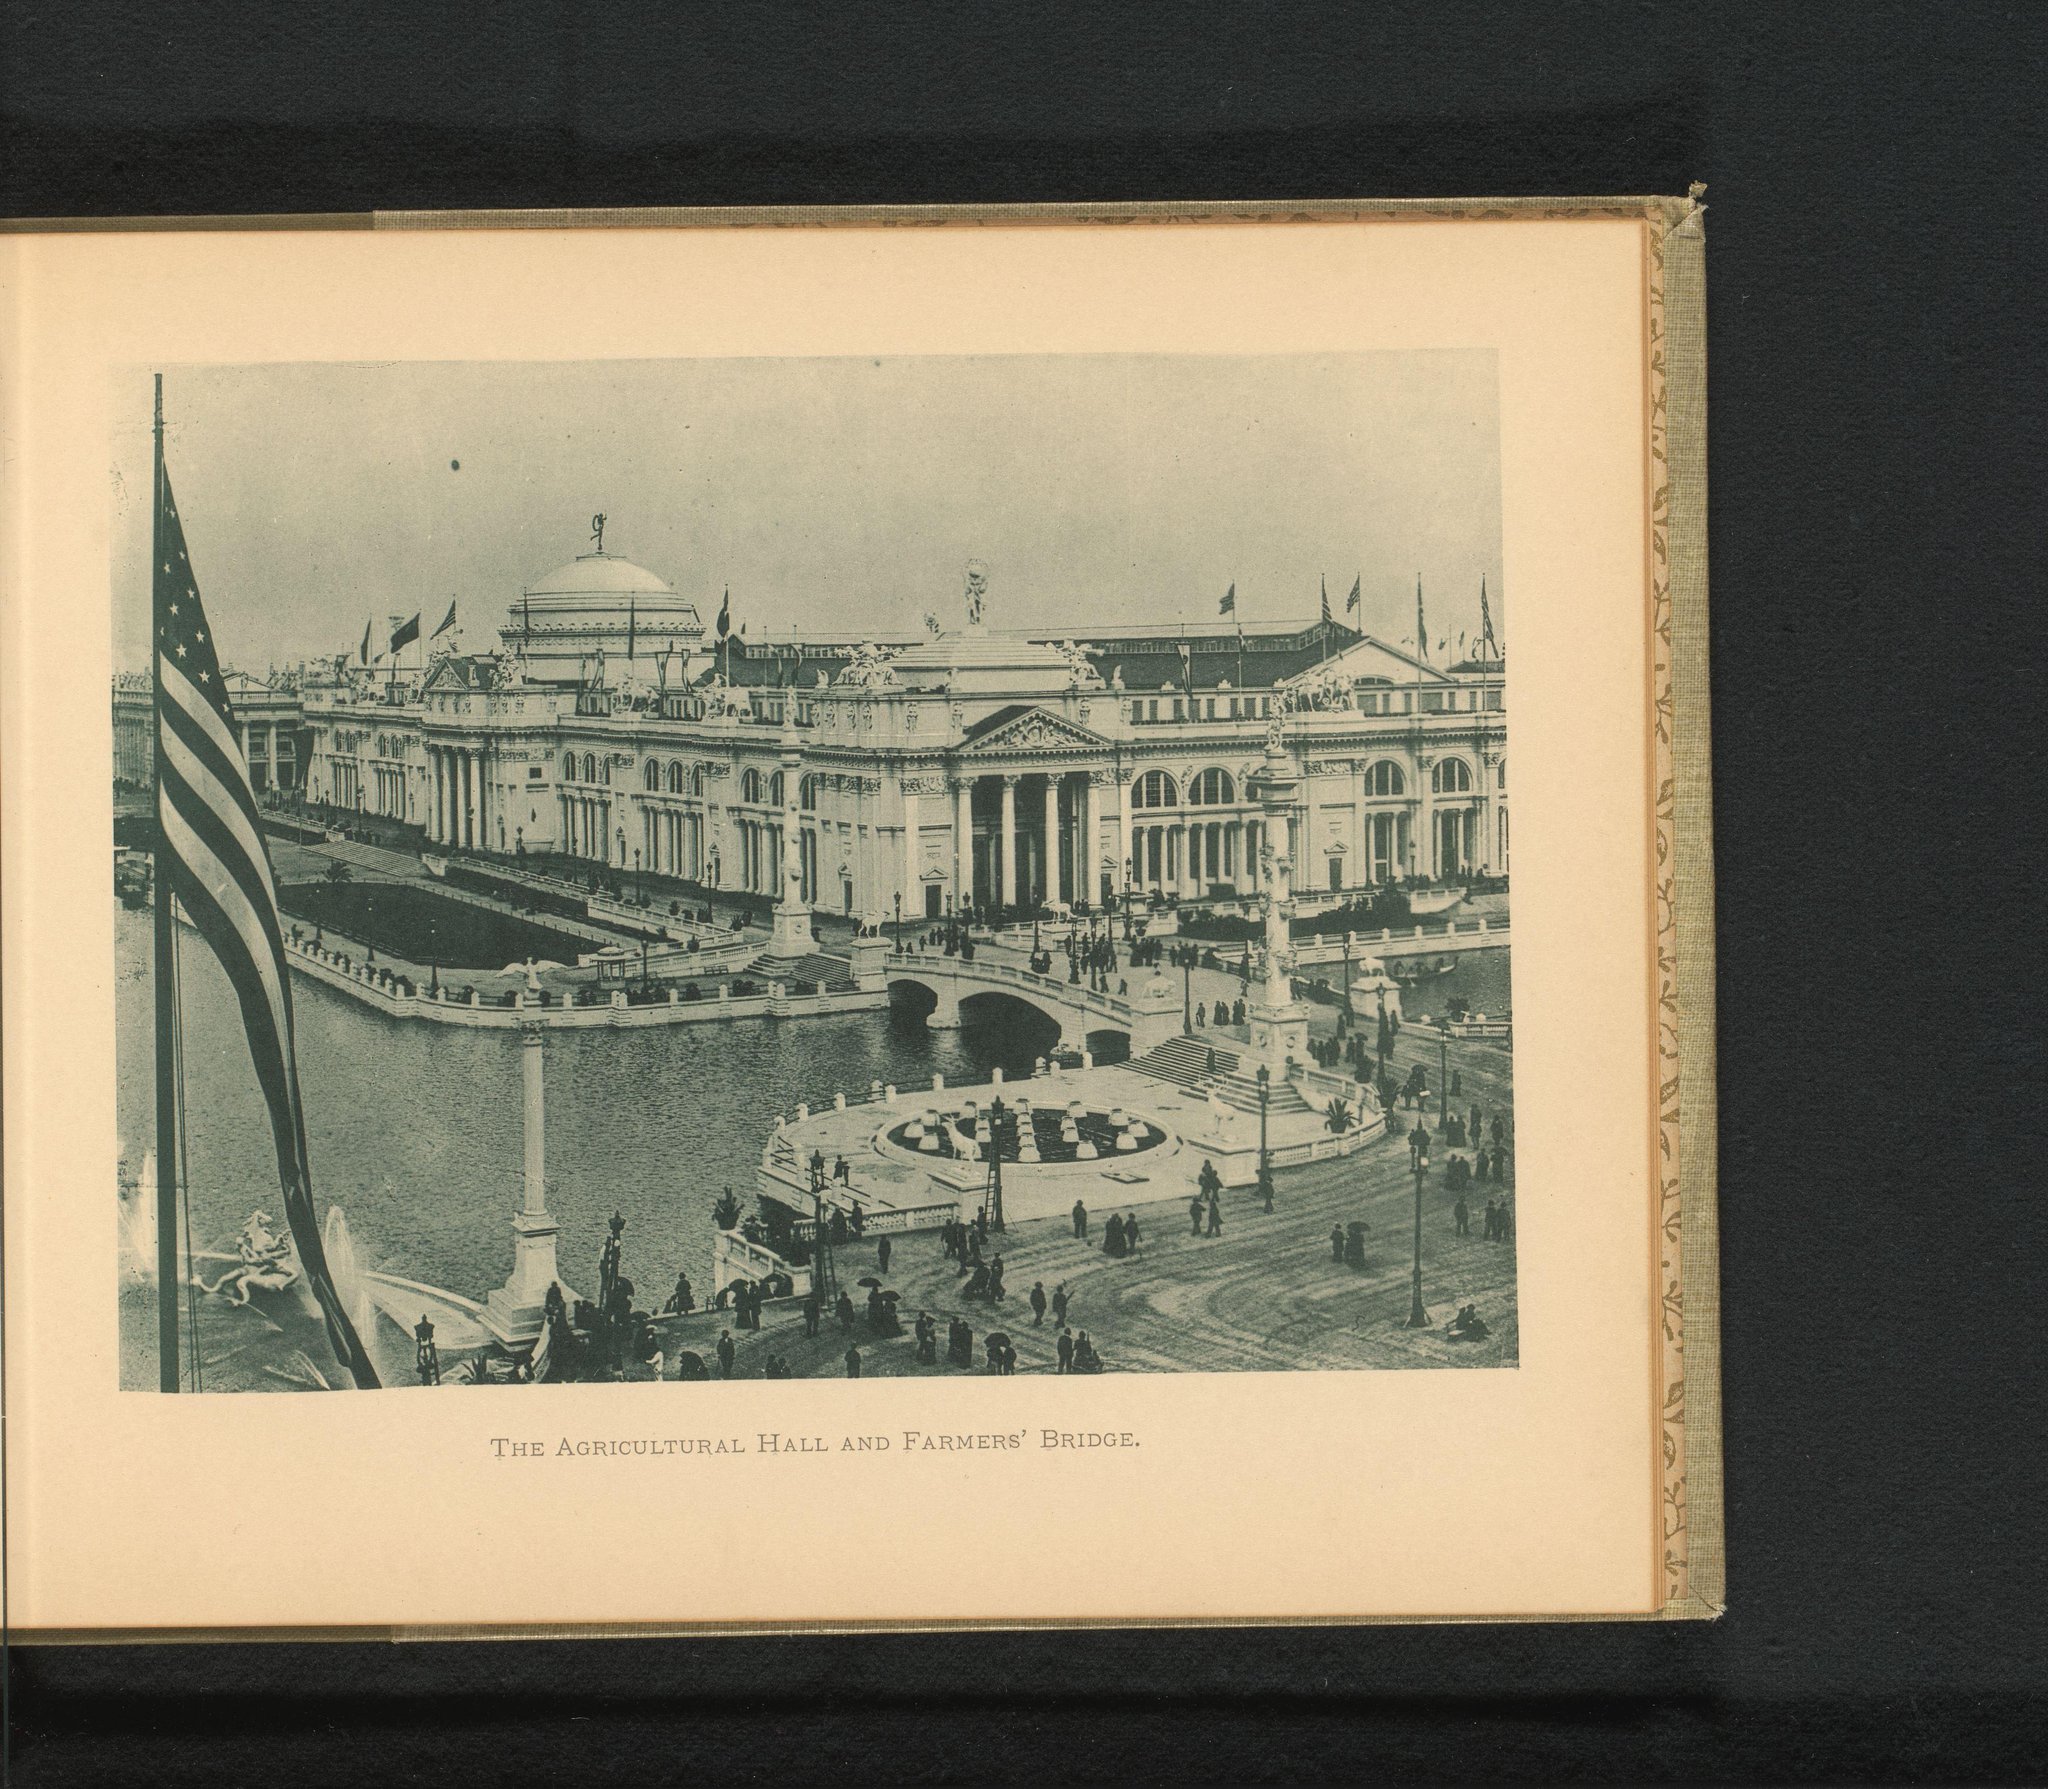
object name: page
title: Gezicht op het landbouwgebouw, ontworpen door Charles McKim op de World's Columbian Exposition in Chicago in 1893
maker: Anonymous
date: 1893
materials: paper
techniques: photograph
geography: chicago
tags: world fair, world exhibition, pond, pool, bridge